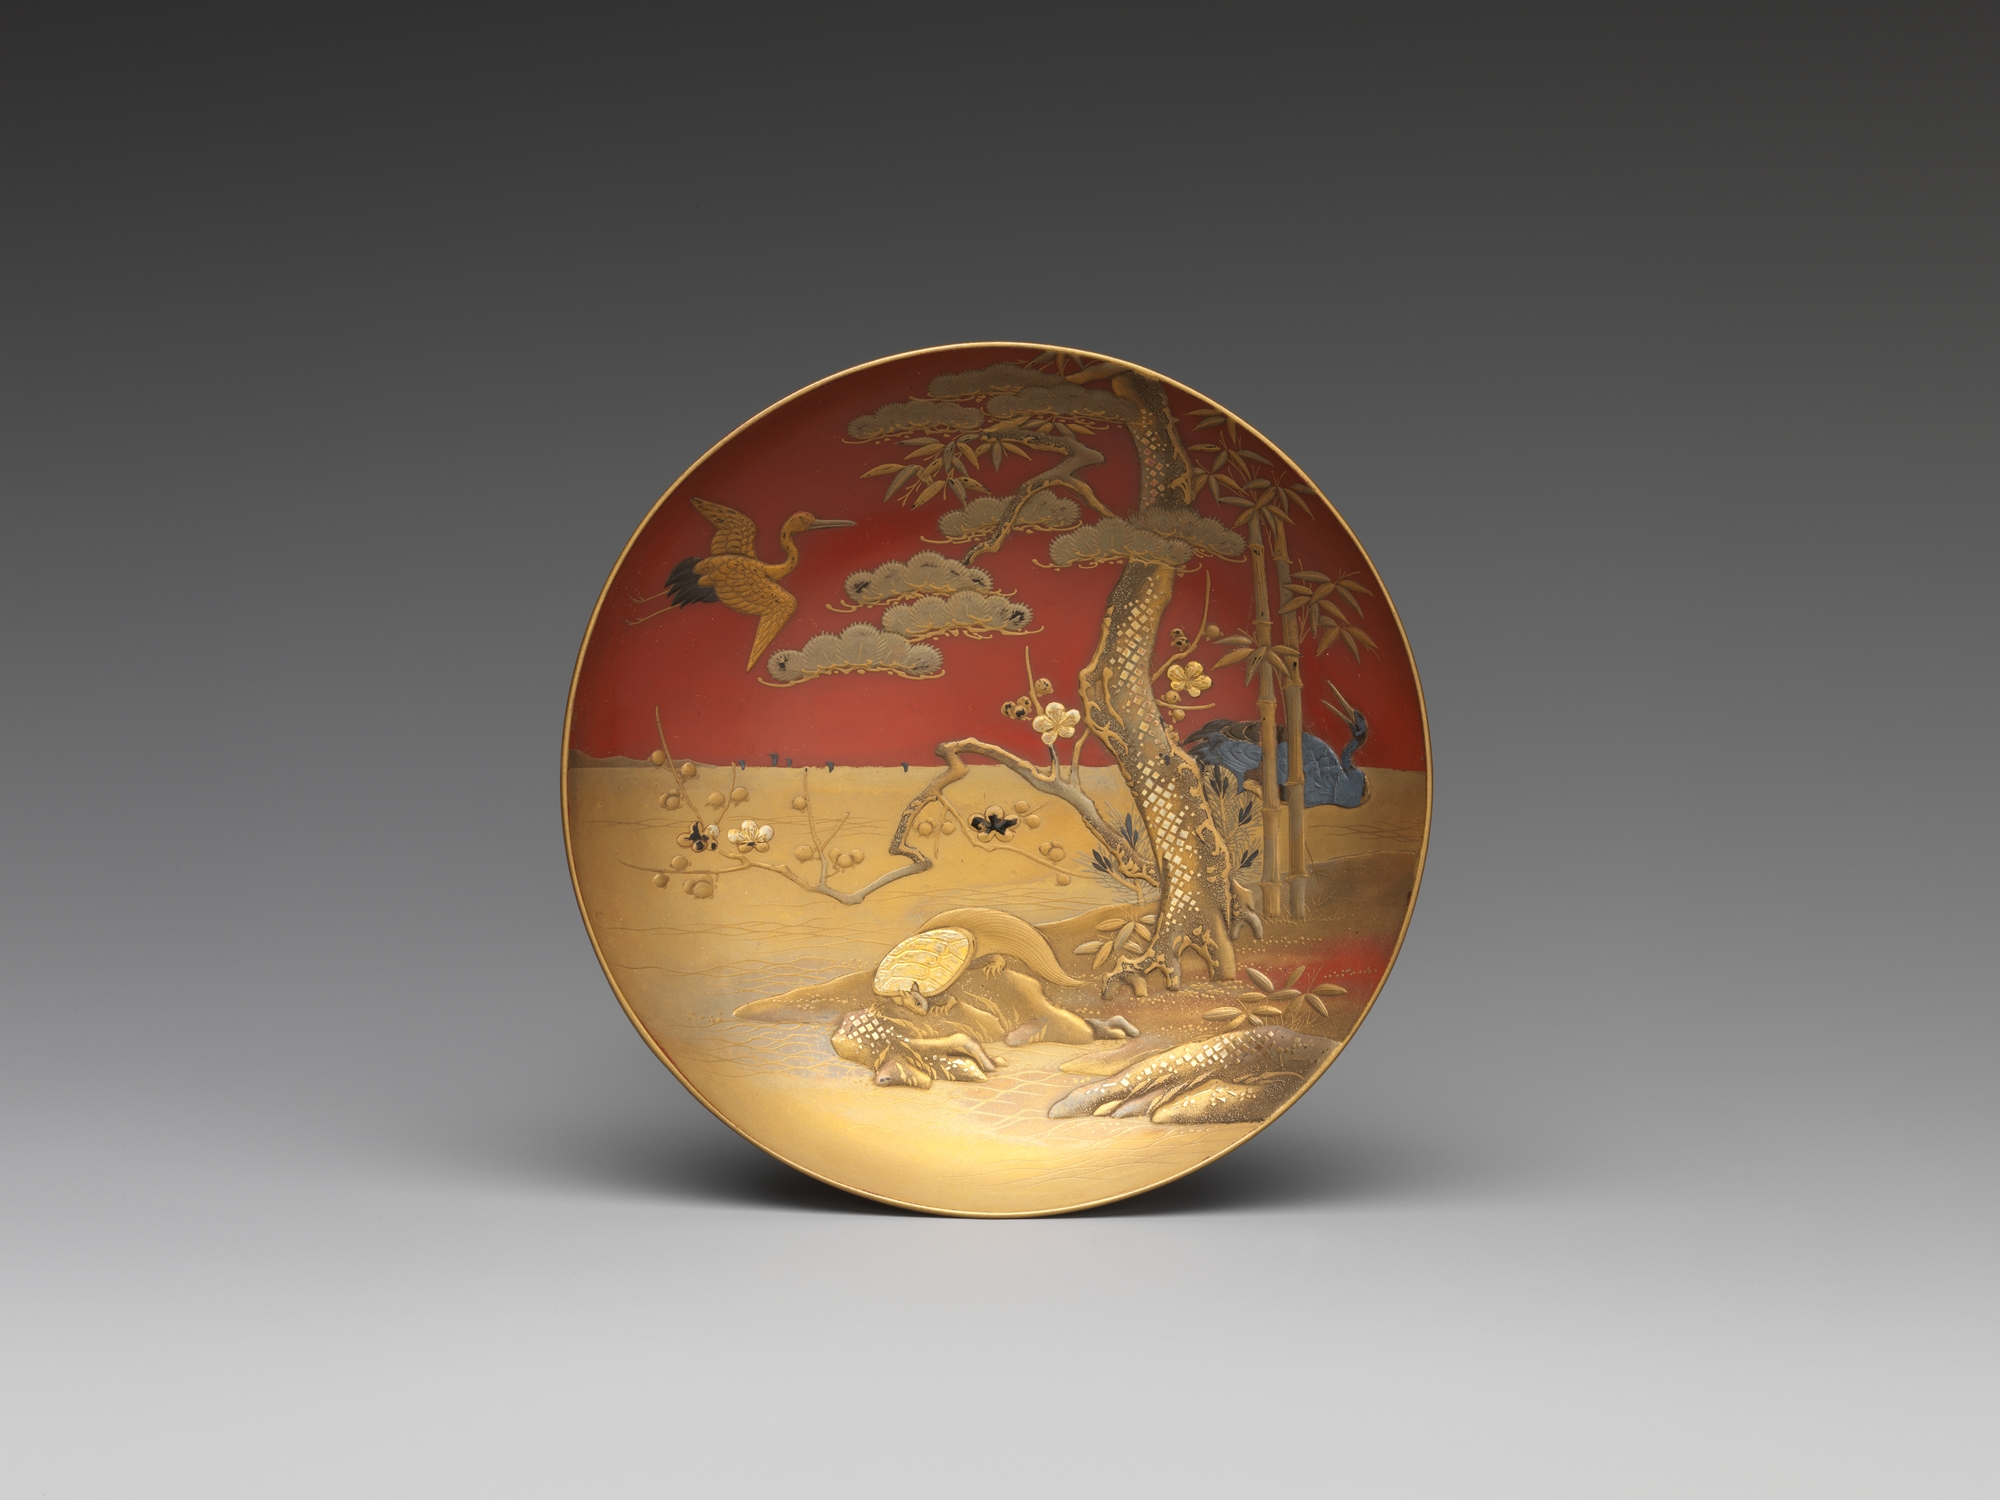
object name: wine cup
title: One of a Pair of Wine Cups (Sakazuki) with Mount Hōrai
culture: japanese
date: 1801-1900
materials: foil, gold, lacquer, silver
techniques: hiramakie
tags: cranes,flowers,trees